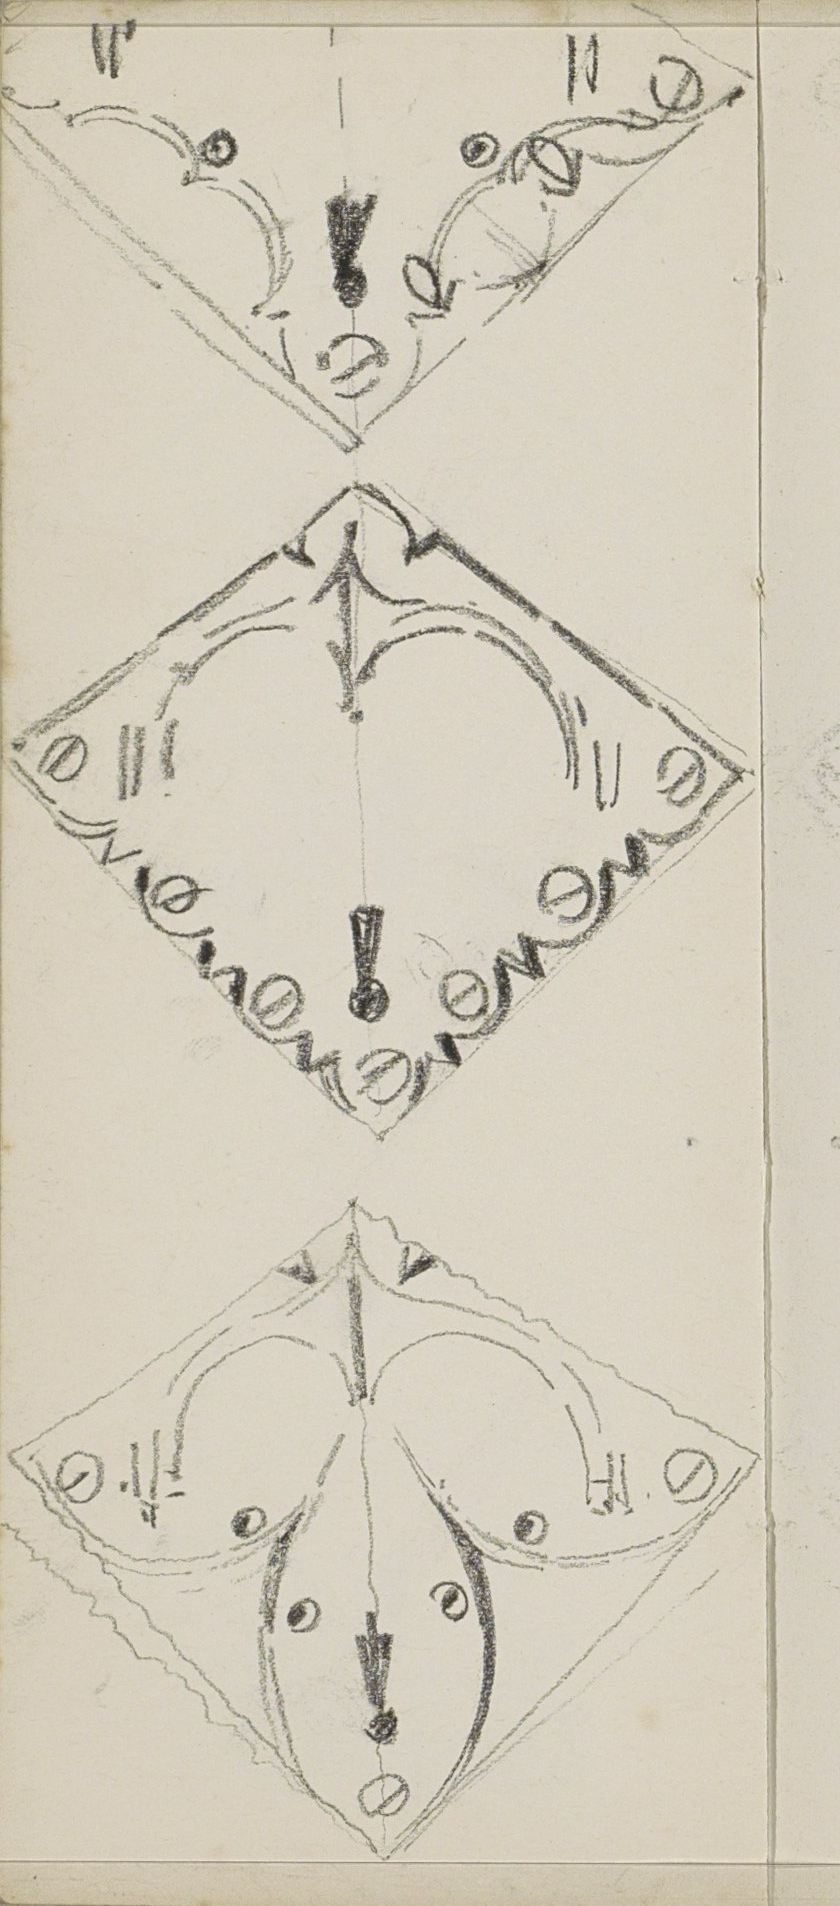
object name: sketchbook leaf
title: Ruitvormige ornamenten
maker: gerrit willem dijsselhof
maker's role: designer, draughtsman, print maker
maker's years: 1866-1924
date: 1876-1924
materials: chalk, paper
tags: foliage, tendrils, branches ~ ornament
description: Onder andere een ornament met een bladmotief. Blad 34 verso uit een schetsboek met 40 bladen.